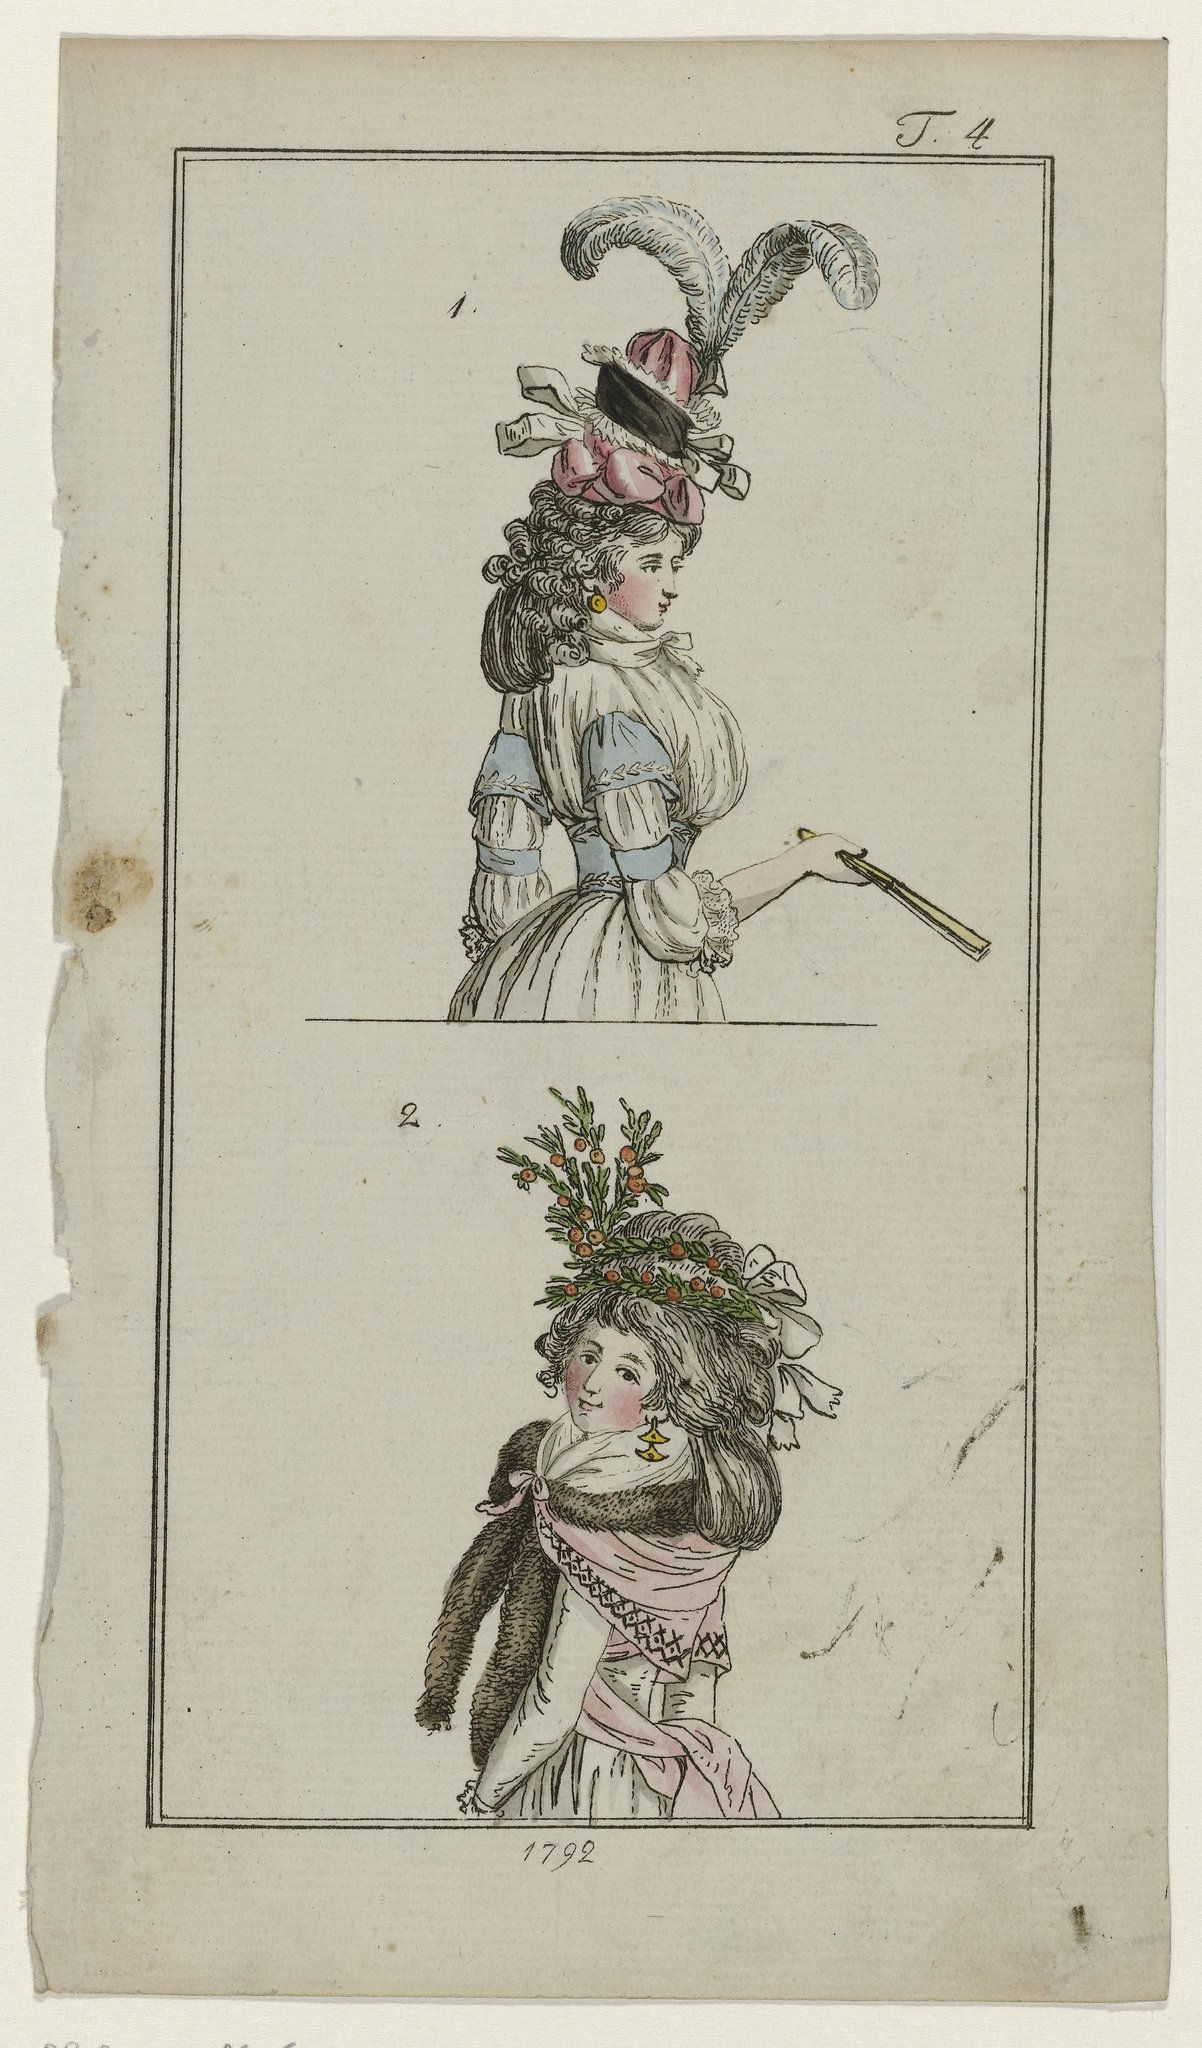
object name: fashion print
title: Journal des Luxus und der Moden, 1792, T 4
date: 1792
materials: paper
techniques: etching, hand coloring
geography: weimar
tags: ear-rings (+ women's clothes), clothing for the upper part of the body (shawl) (+ women's clothes), neck-gear ~ clothing (palatine) (+ women's clothes), head-gear (+ women's clothes), fashion plates, dress, gown (+ women's clothes), fan (+ women's clothes), piece of clothing covering the breast or décolleté (fichu) (+ women's clothes)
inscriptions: date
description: Twee vrouwen, ten halven lijve, op de rug gezien, genummerd 1 en 2. Nummer 1: vrouw in een japon met driekwart mouwen. Accessoires: hoge hoed met struisveren, oorbel in het rechteroor, fichu, waaier. Onder: vrouw in een japon met lange mouwen. Het haar versierd met linten en guirlandes. Verdere accessoires: oorbel in het linkeroor, 'palatine'(?) van bont, sjaal met geometrisch patroon. Prent uit het modetijdschrift Journal des Luxus und der Moden, uitgegeven door Friedrich Justin Bertuch en Georg Melchior Kraus, Weimar, 1786-1826.